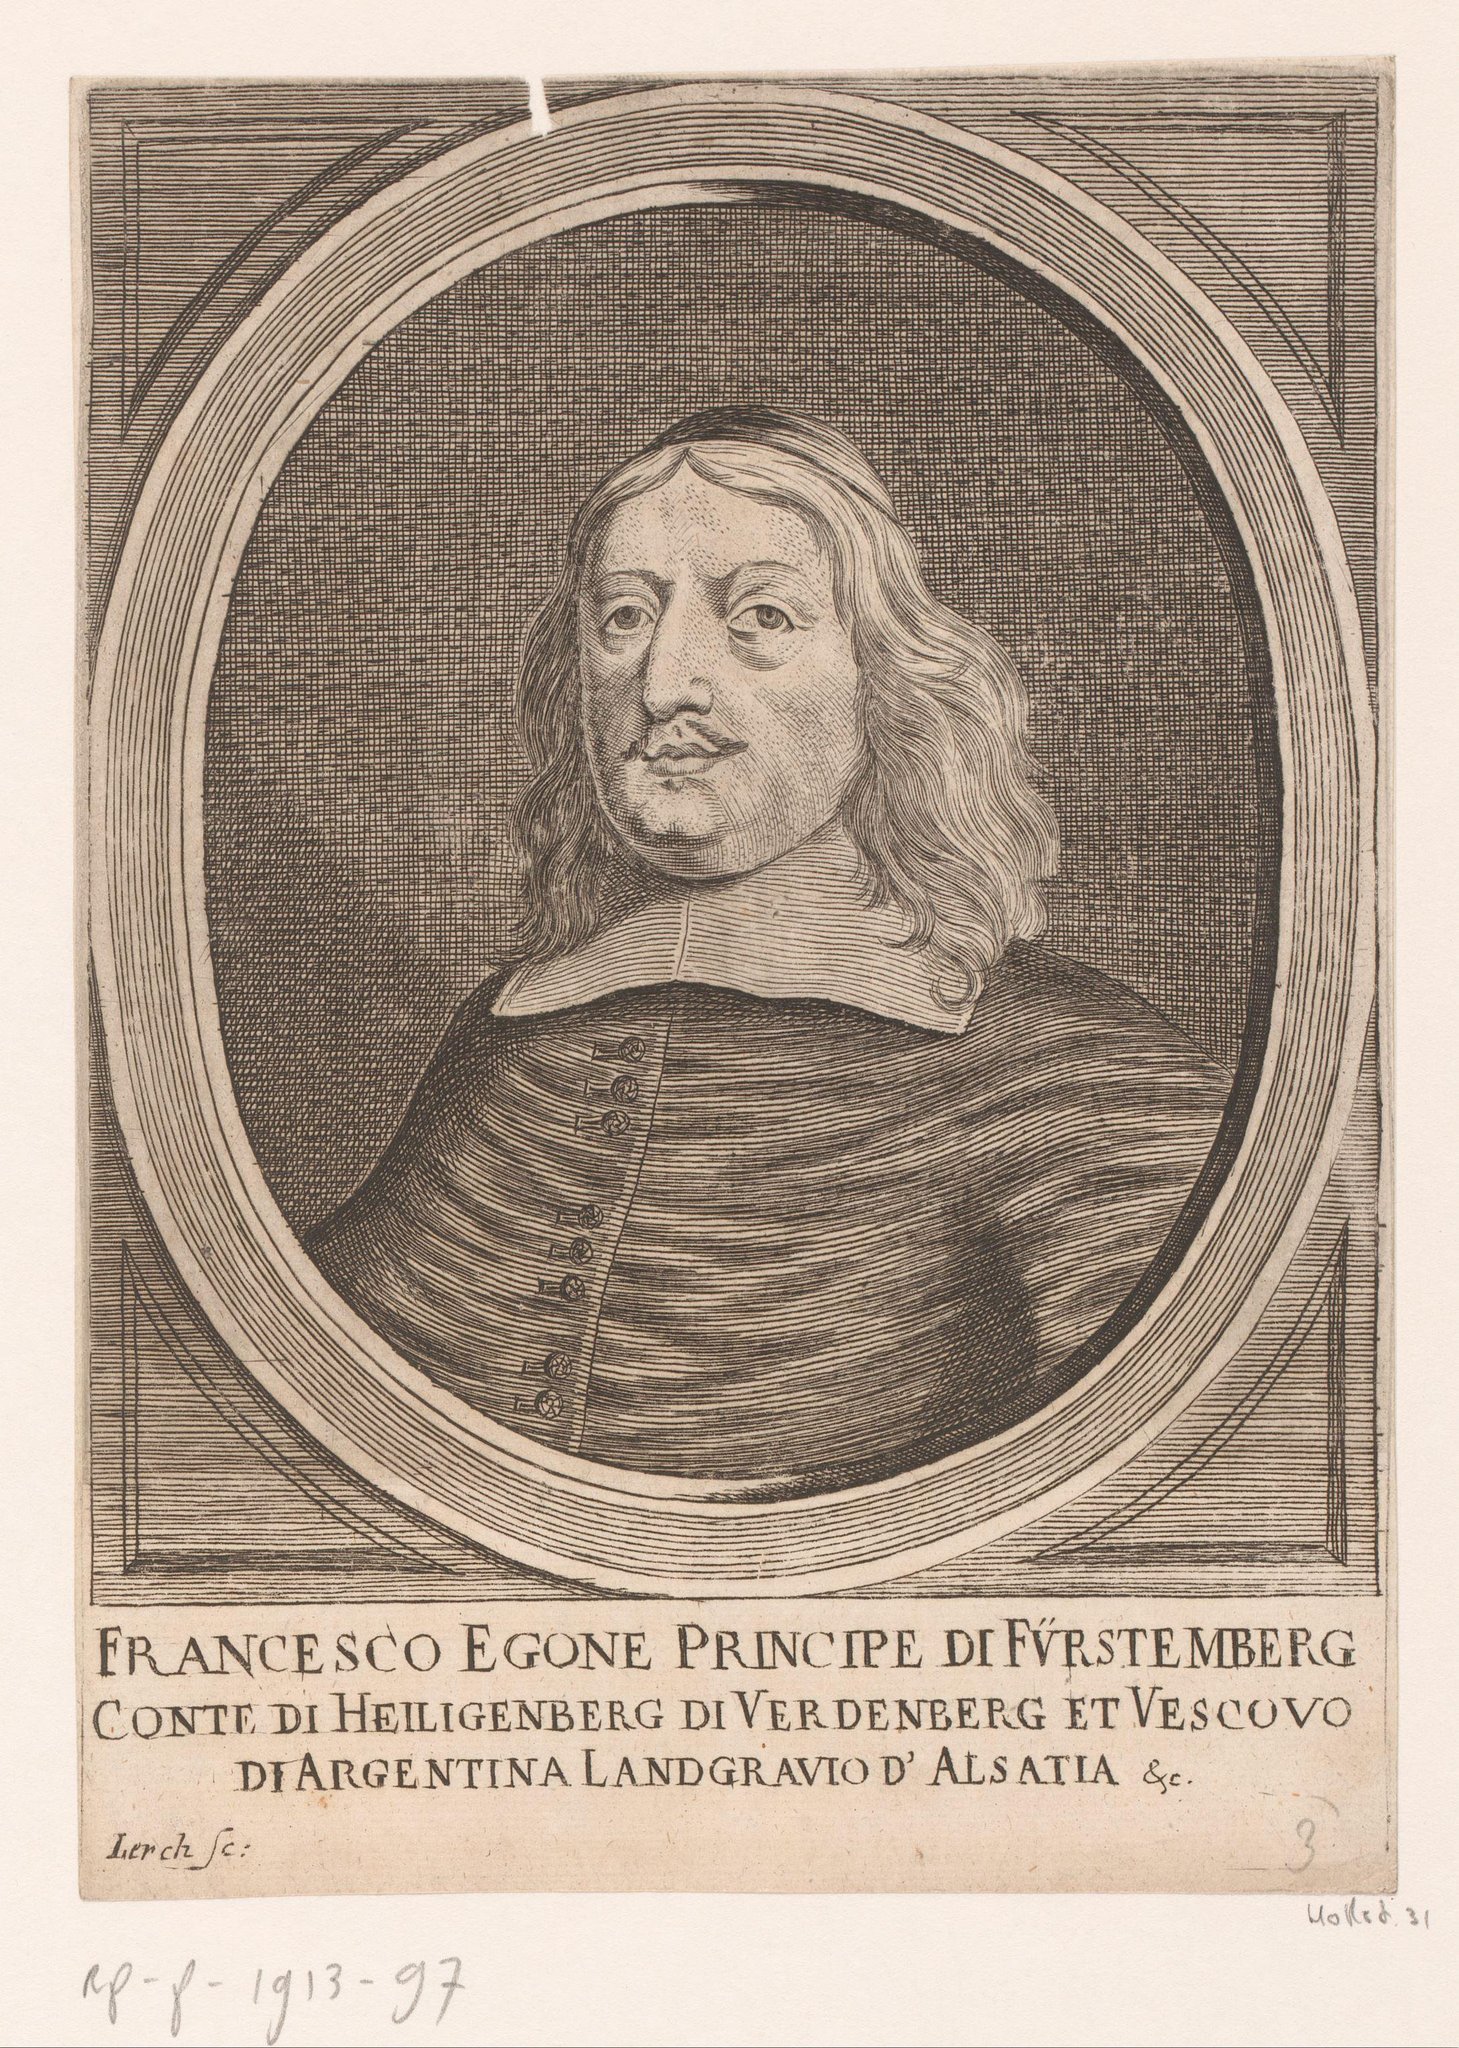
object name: print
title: Portret van Frans Egon, graaf van Fürstenberg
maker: johann martin lerch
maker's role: print maker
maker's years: 1643-1693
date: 1660-1685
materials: paper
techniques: engraving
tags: historical persons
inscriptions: collector's mark: Lugt 2228